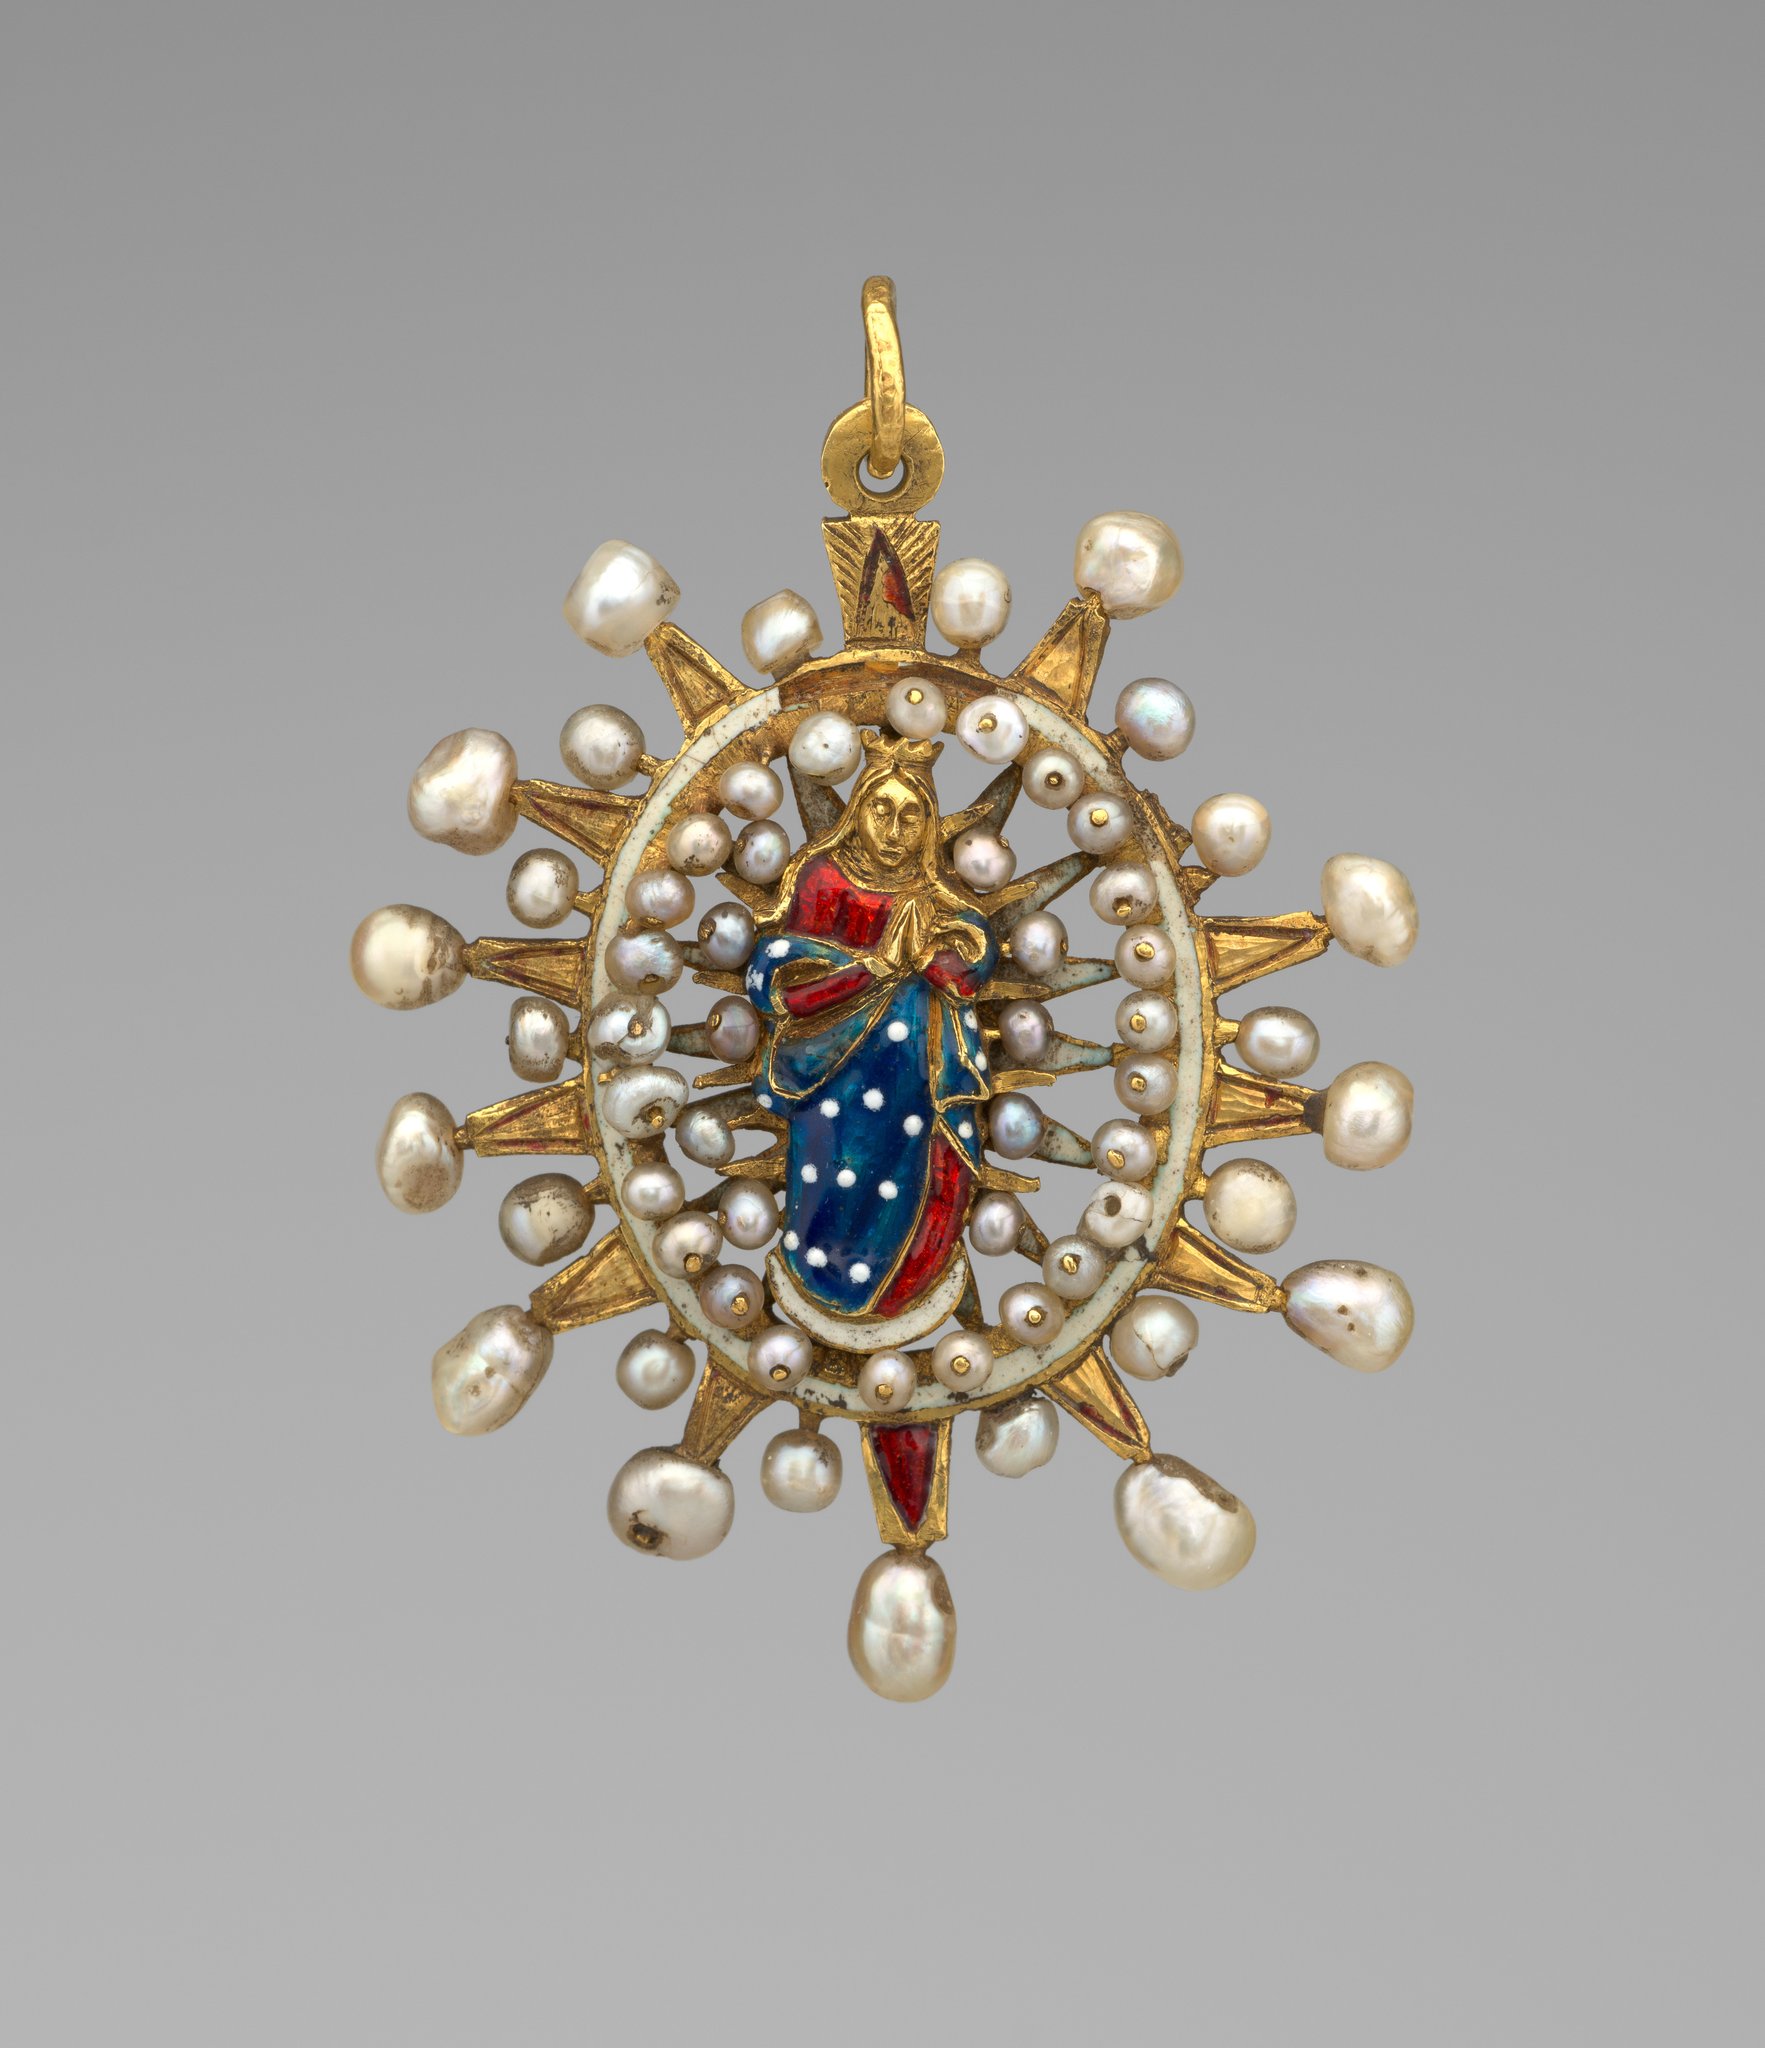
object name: pendant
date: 1601-1700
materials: enamel, gold, pearl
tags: virgin mary